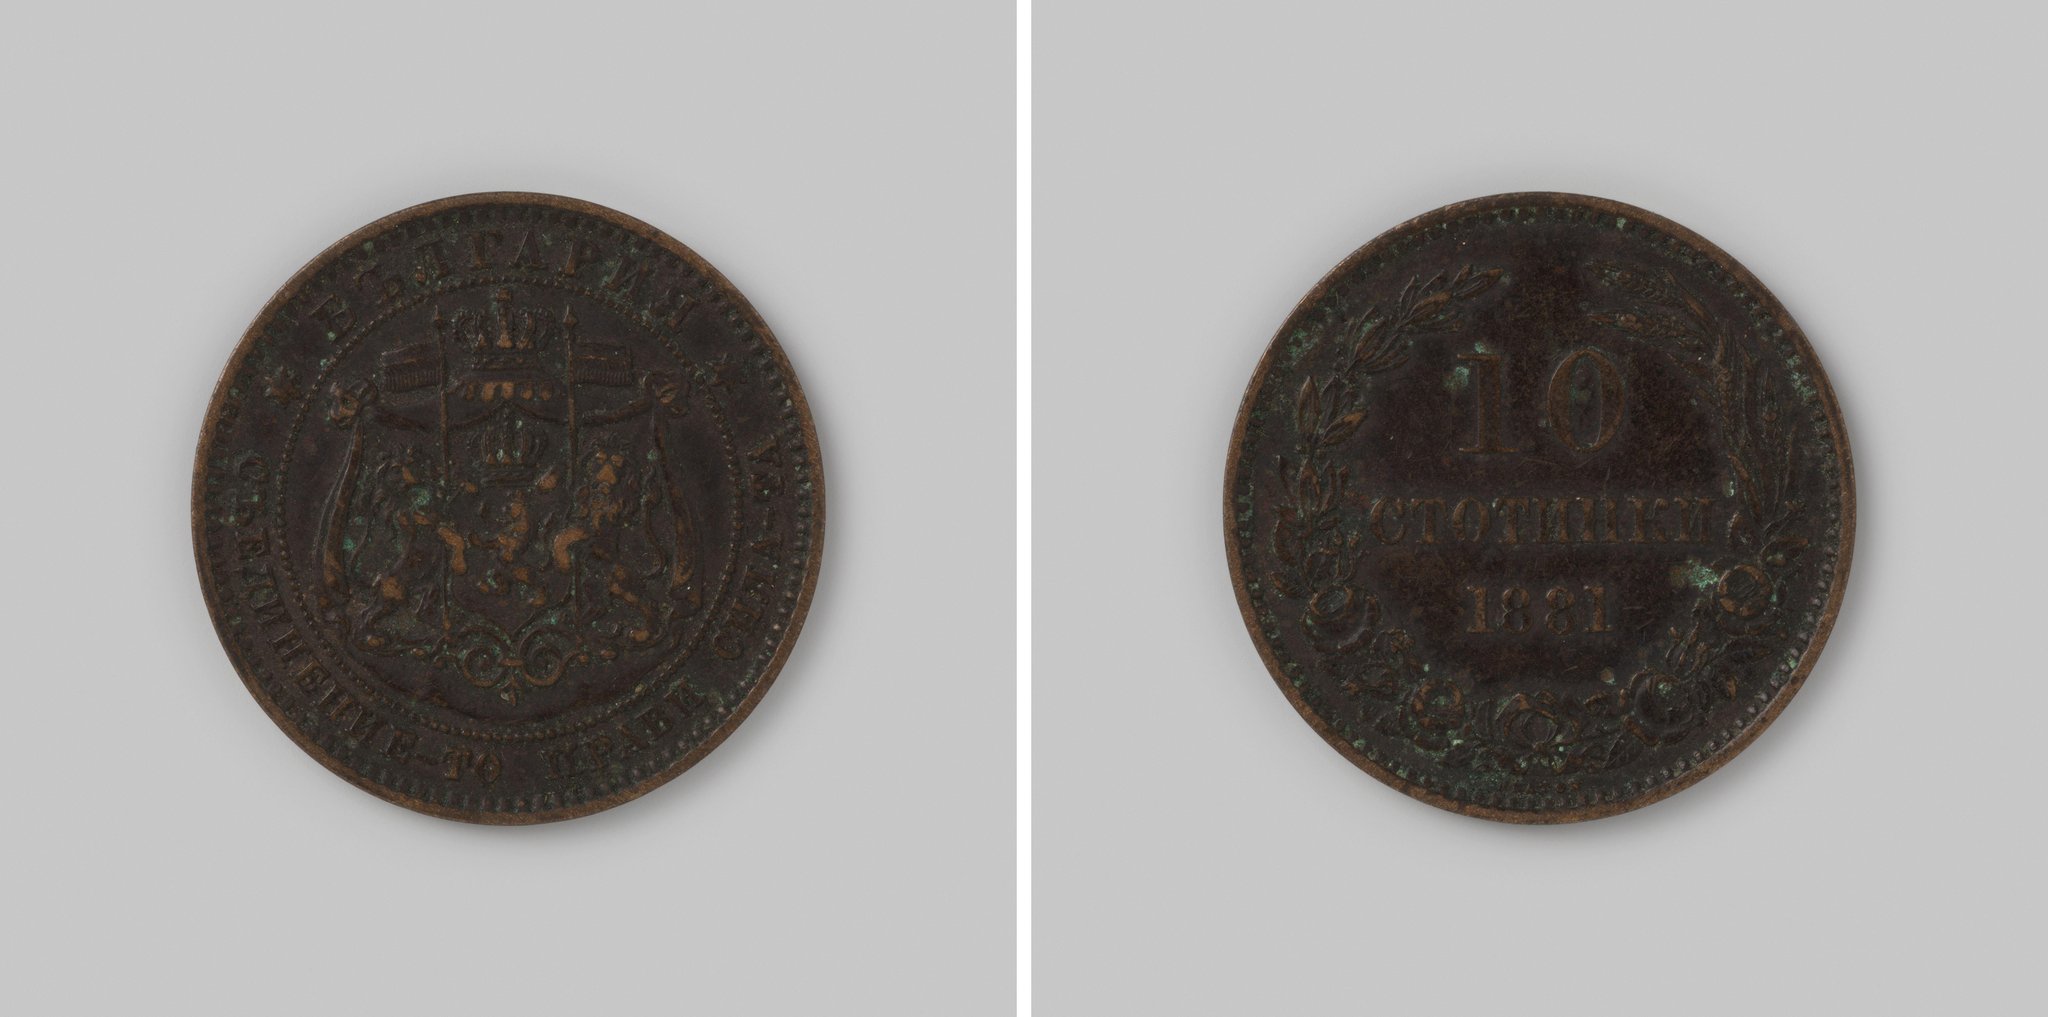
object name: coin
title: 10 stotinki uit Bulgarije van prins Alexander I, 1881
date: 1881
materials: bronze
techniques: striking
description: Bronzen munt. Voorzijde: op versierde gekroonde mantel door twee leeuwen met vanen als schildhouders gehouden gekroond wapenschild. Keerzijde: tussen twee samengebonden takken waarde-aanduiding in twee regels, waaronder jaartal. Gladde rand.